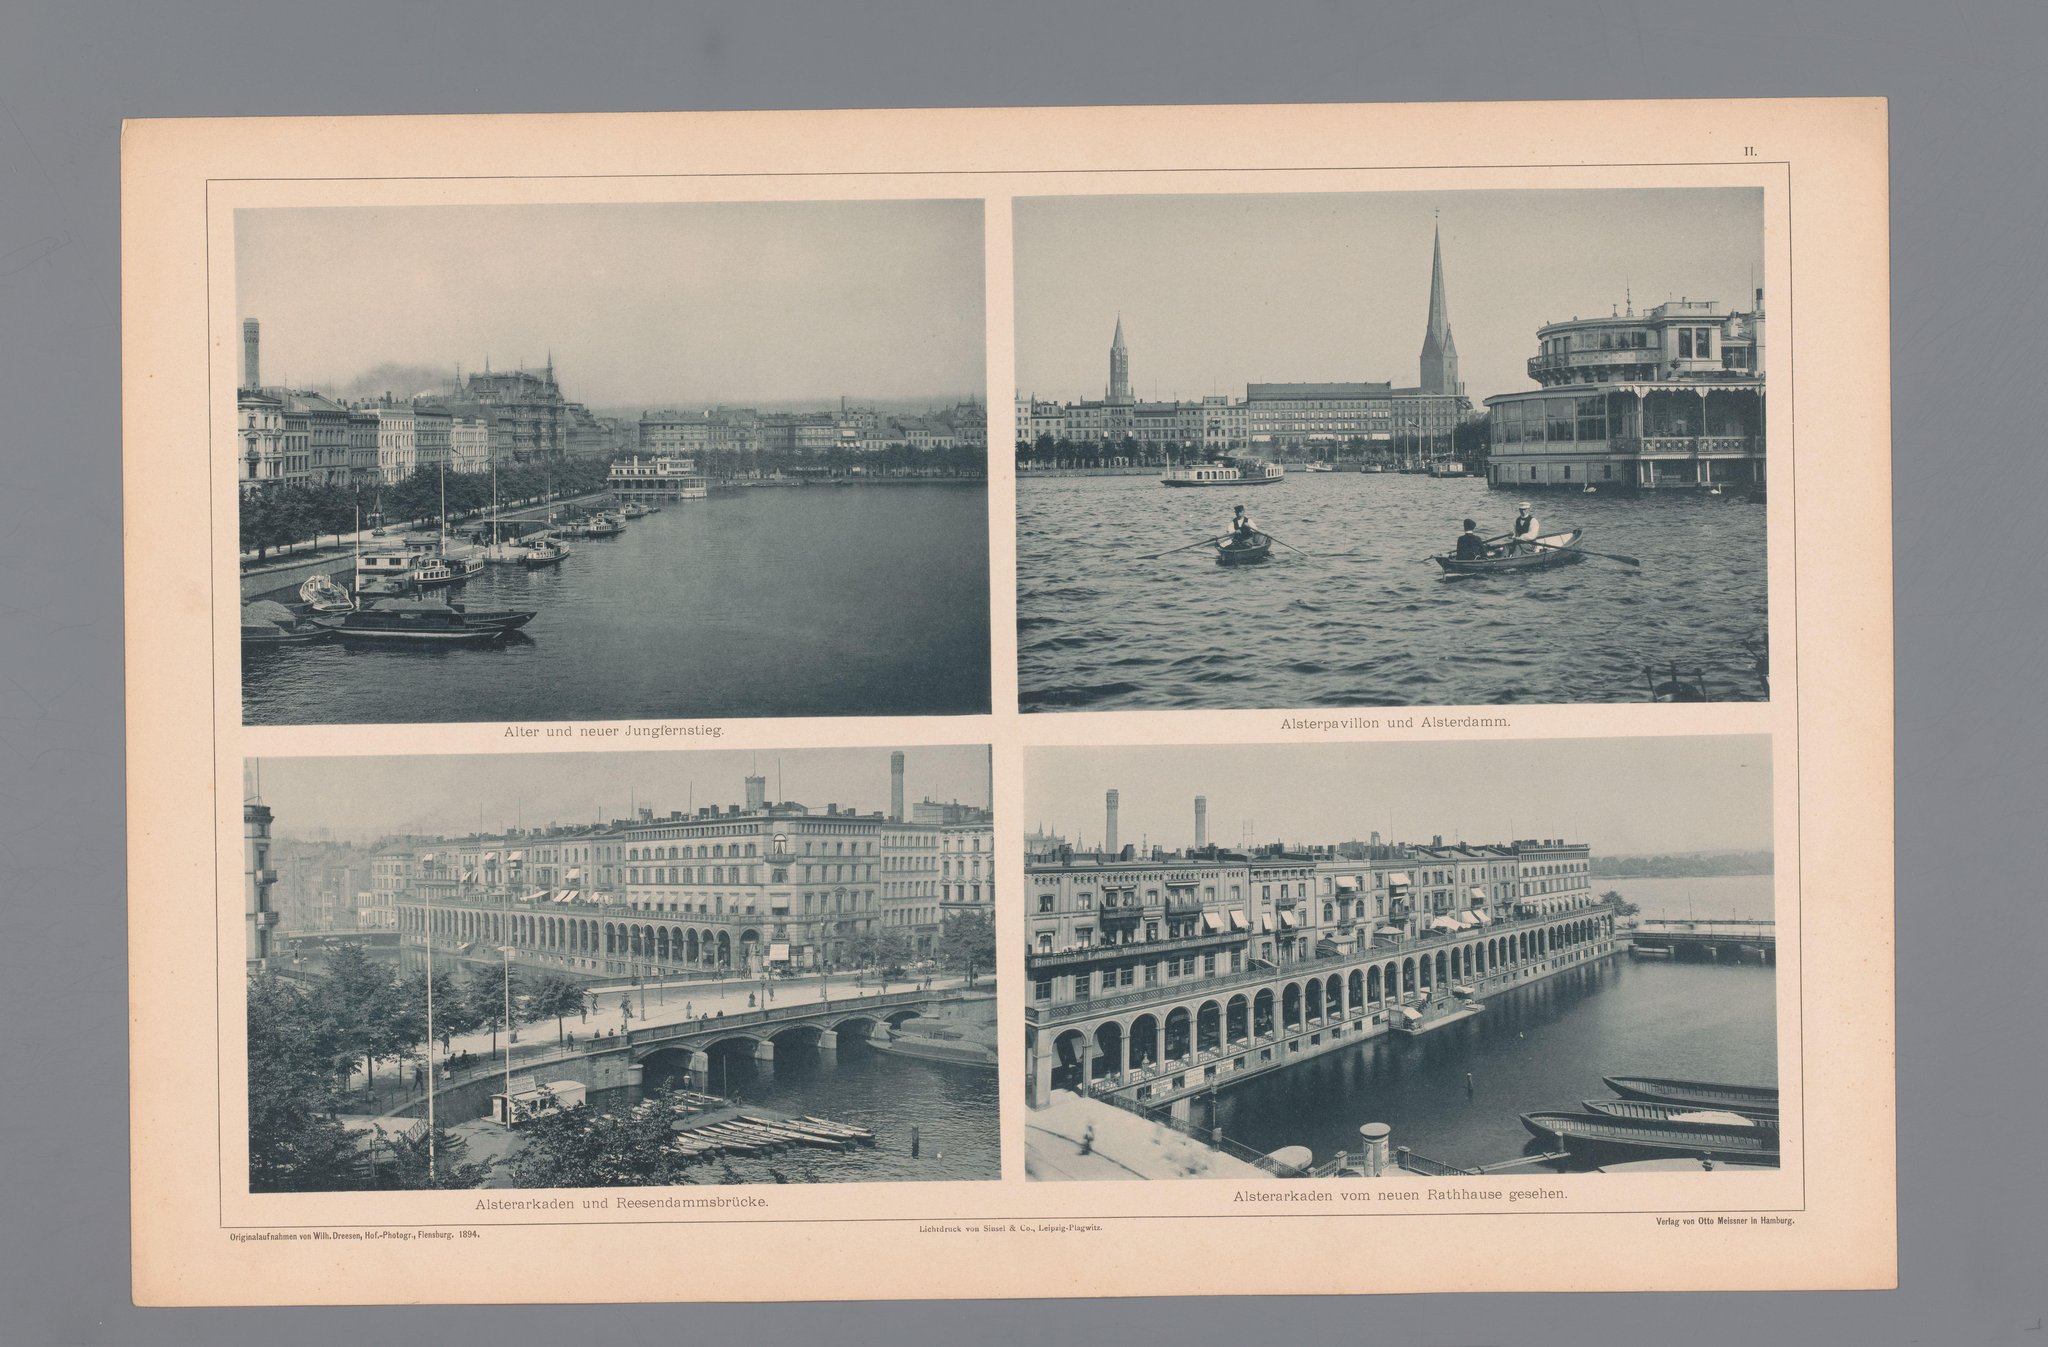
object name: photomechanical print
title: Alsterarkaden und Reesendammsbrücke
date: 1894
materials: paper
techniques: photograph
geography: hamburg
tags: bridge in city across river, canal, etc., street, prospect of city, town panorama, silhouette of city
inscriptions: number: ‘II.’, inscription: ‘Originalaufnahmen von Wilh. Dreesen, Hof.-Photogr., Flensburg. 1894.’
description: Deze prenten maken deel uit van een omslag met 126 prenten op 37 bladen en een tekstblad.